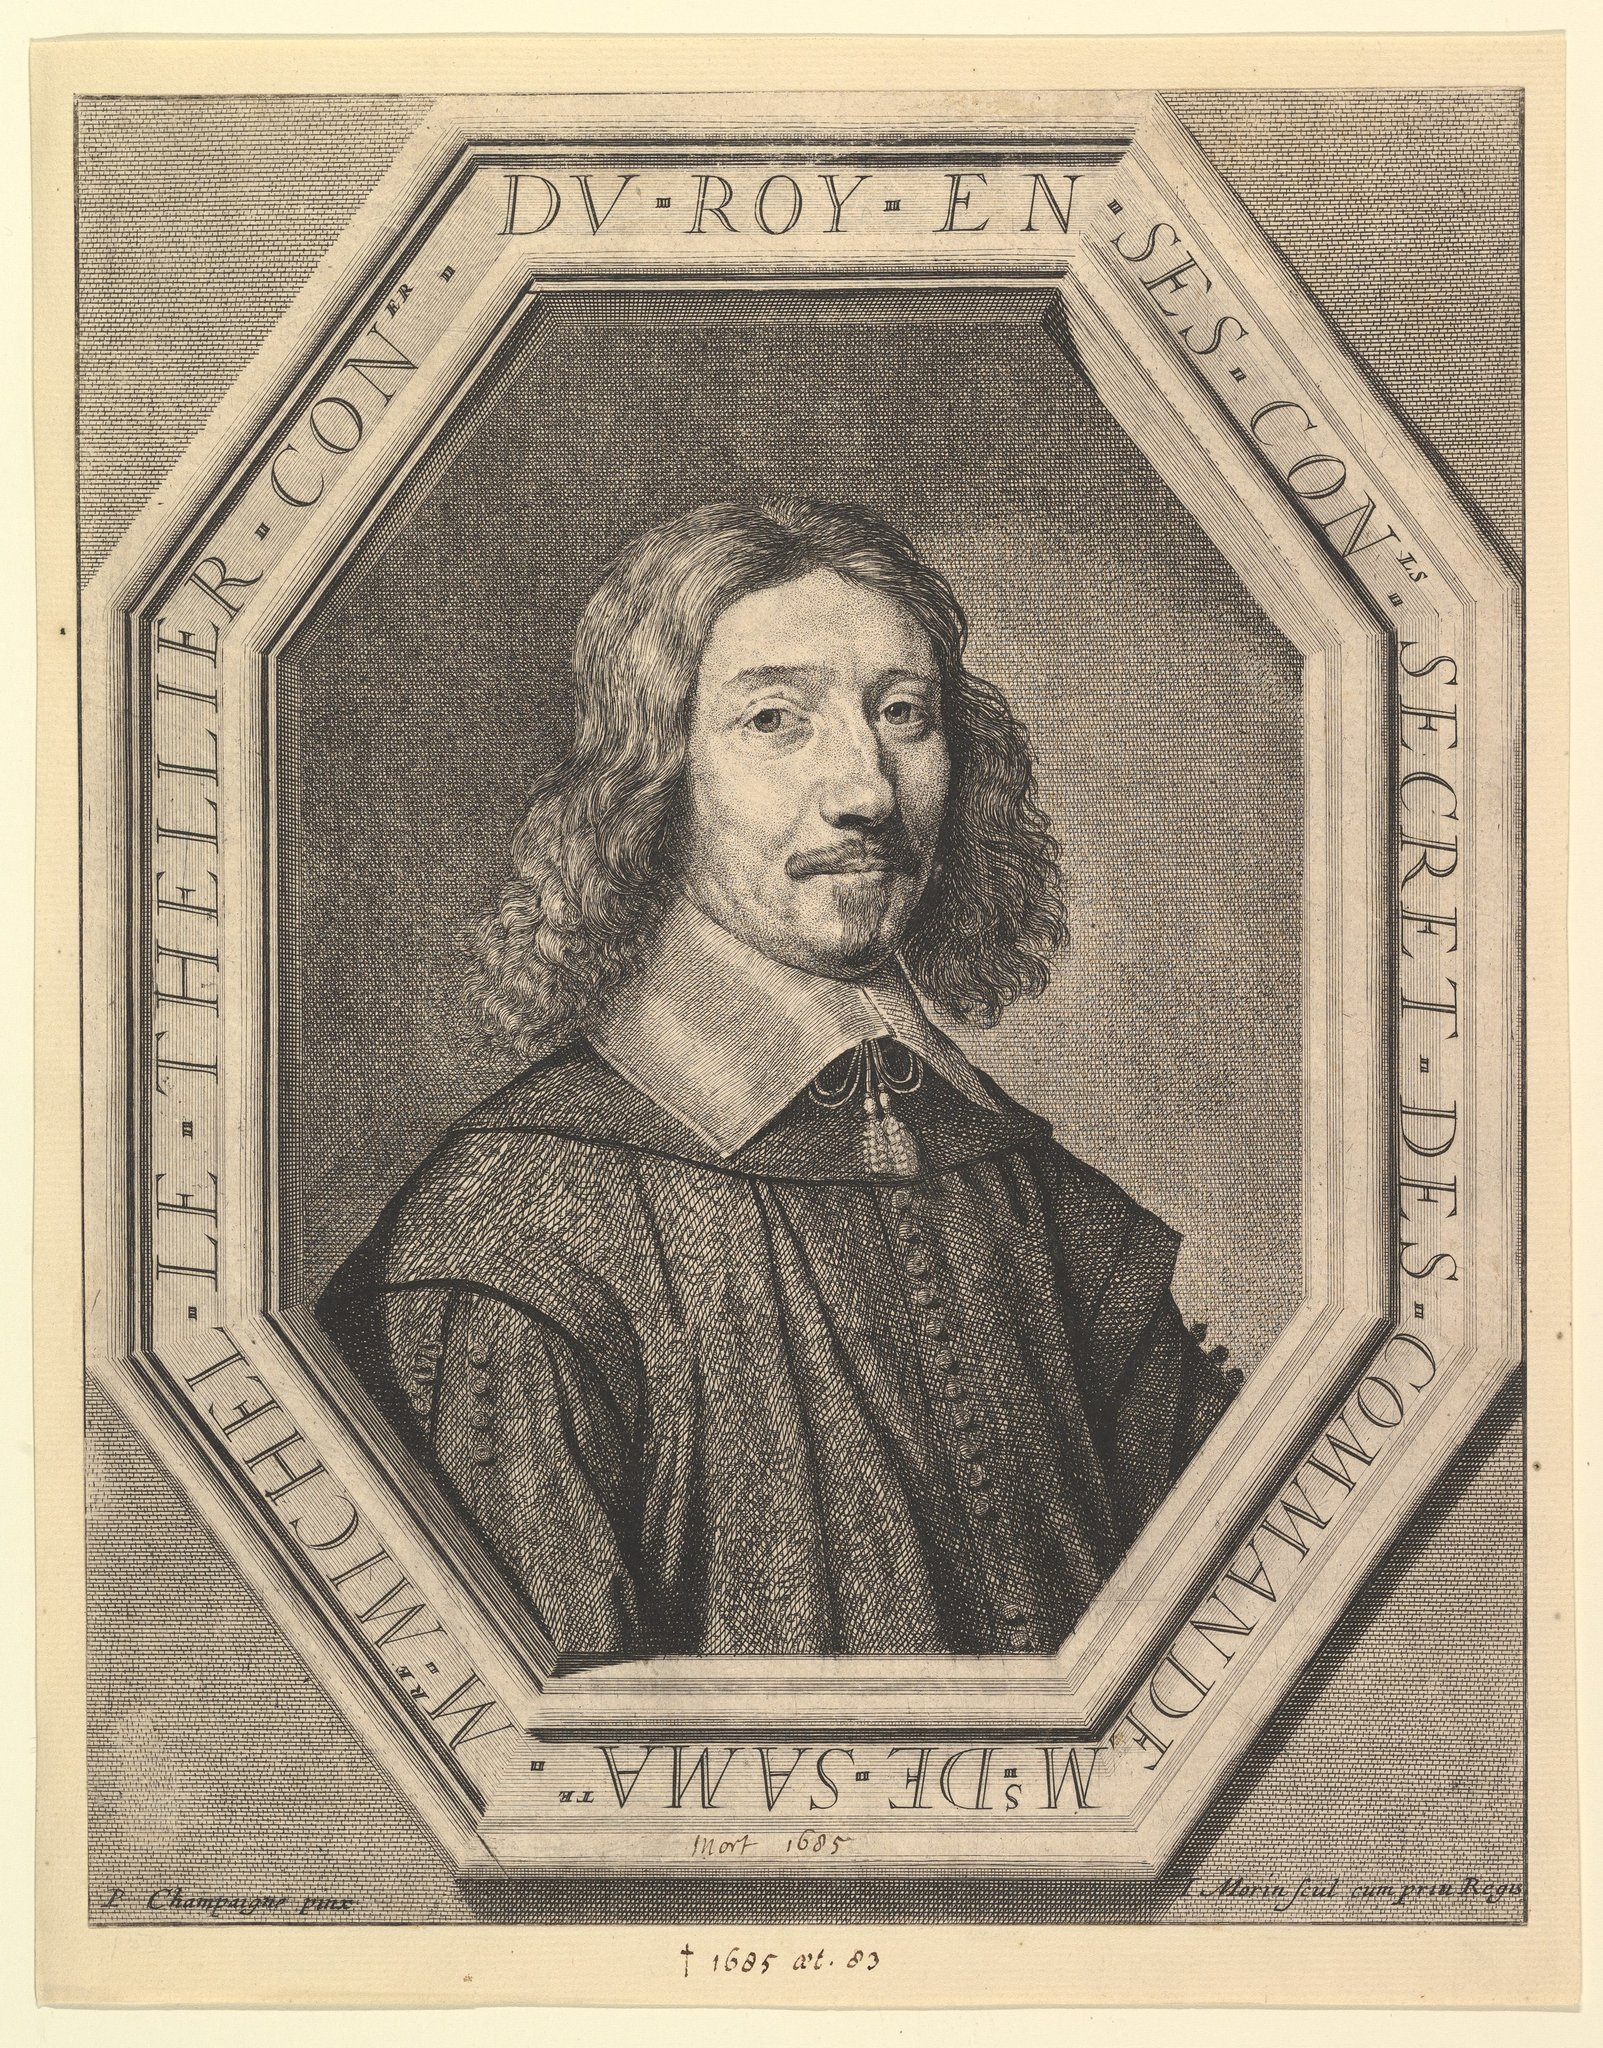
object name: print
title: Michel Le Tellier, conseiller du roi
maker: jean morin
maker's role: artist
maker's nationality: french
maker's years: 1605-1650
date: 1620-1650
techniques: etching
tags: men,portraits